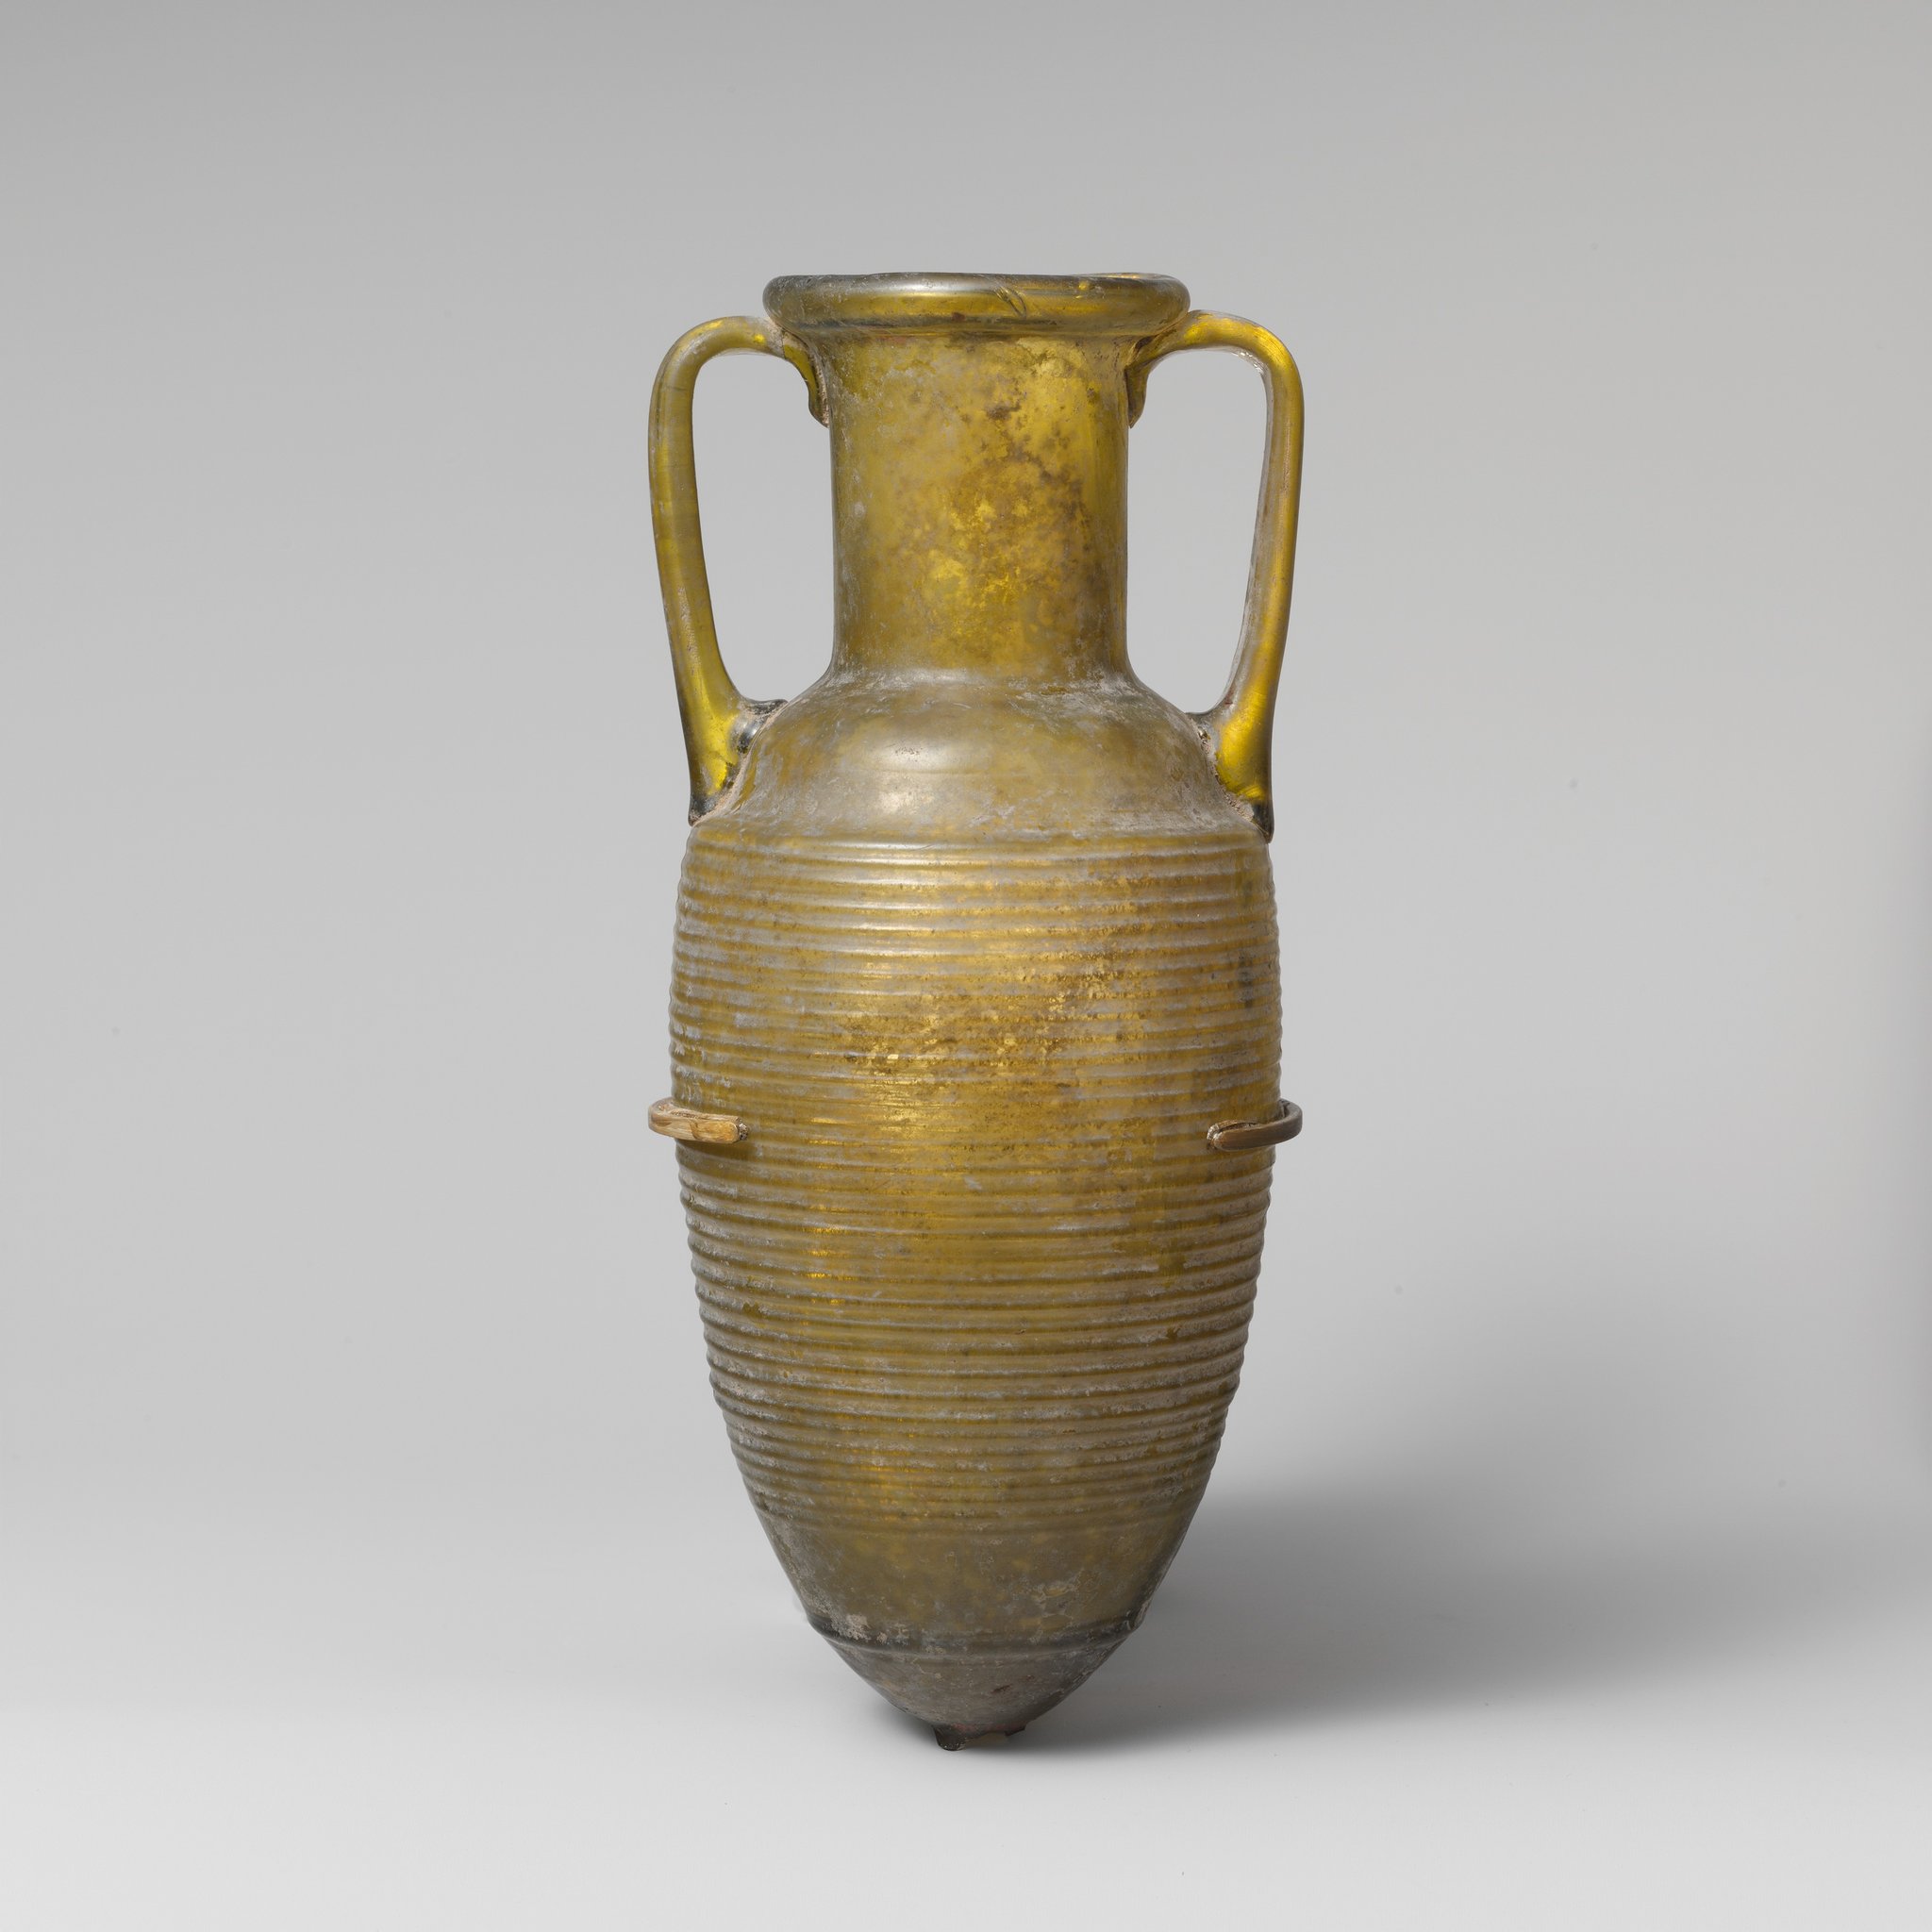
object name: amphora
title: Glass amphora (jar)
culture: roman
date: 1-33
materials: glass